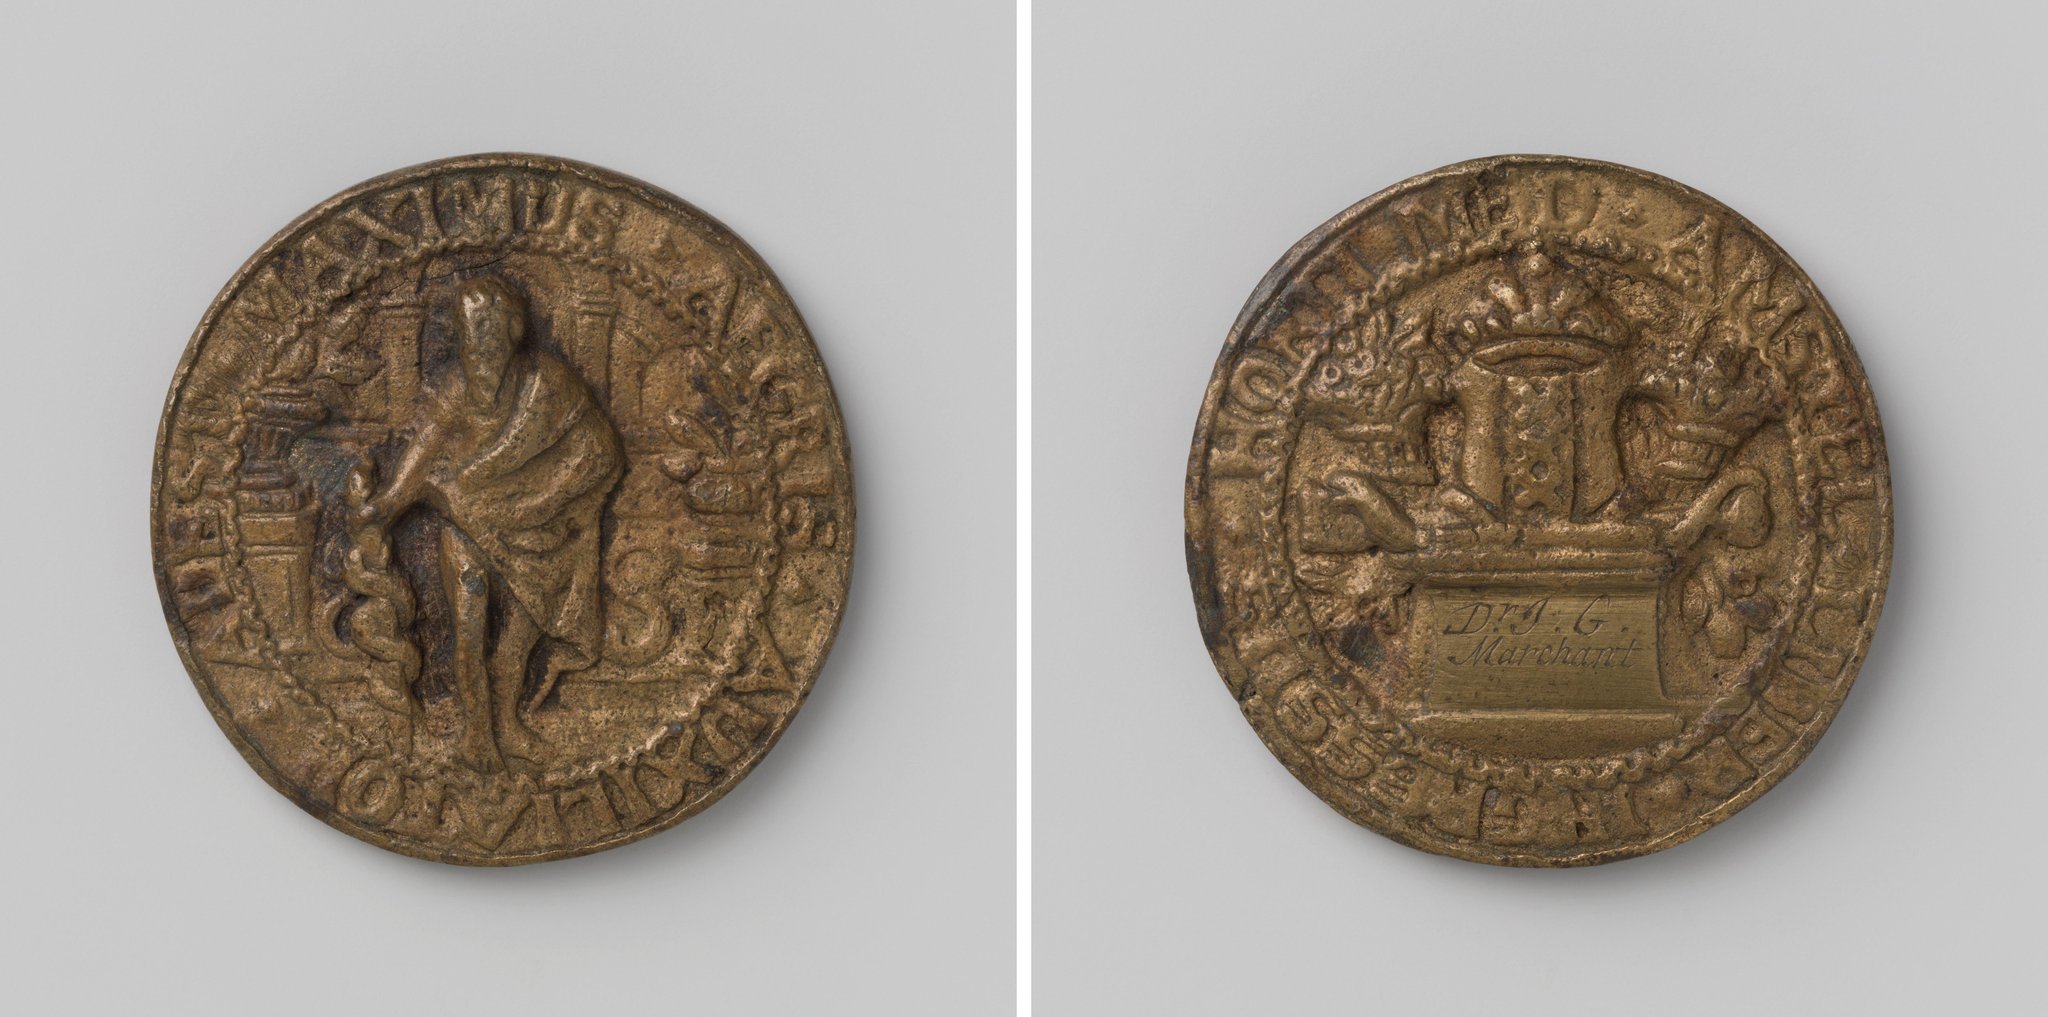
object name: toegangspenning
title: Collegium Medicum te Amsterdam, toegangspenning voor de hortus medicus van Dr. J.G. Marchant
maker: willem de wijs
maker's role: medailleur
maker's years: 1700-1795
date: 1696-1828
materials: brass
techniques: casting, engraving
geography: amsterdam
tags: j.g. marchant, hortus medicus, collegium medicum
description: Messing penning. Voorzijde: Aesculapius met rechterhand leunend op slangestaf en linkerhand onder zijn mantel, staande tussen twee vazen met planten op voetstuk; op achtergrond wand van gebouw binnen omschrift. Keerzijde: gekroond wapenschild tussen twee gevulde hoorns van overvloed boven zalfspatel, waarom slang zich kronkelt, liggend op voetstuk met opschrift binnen omschrift